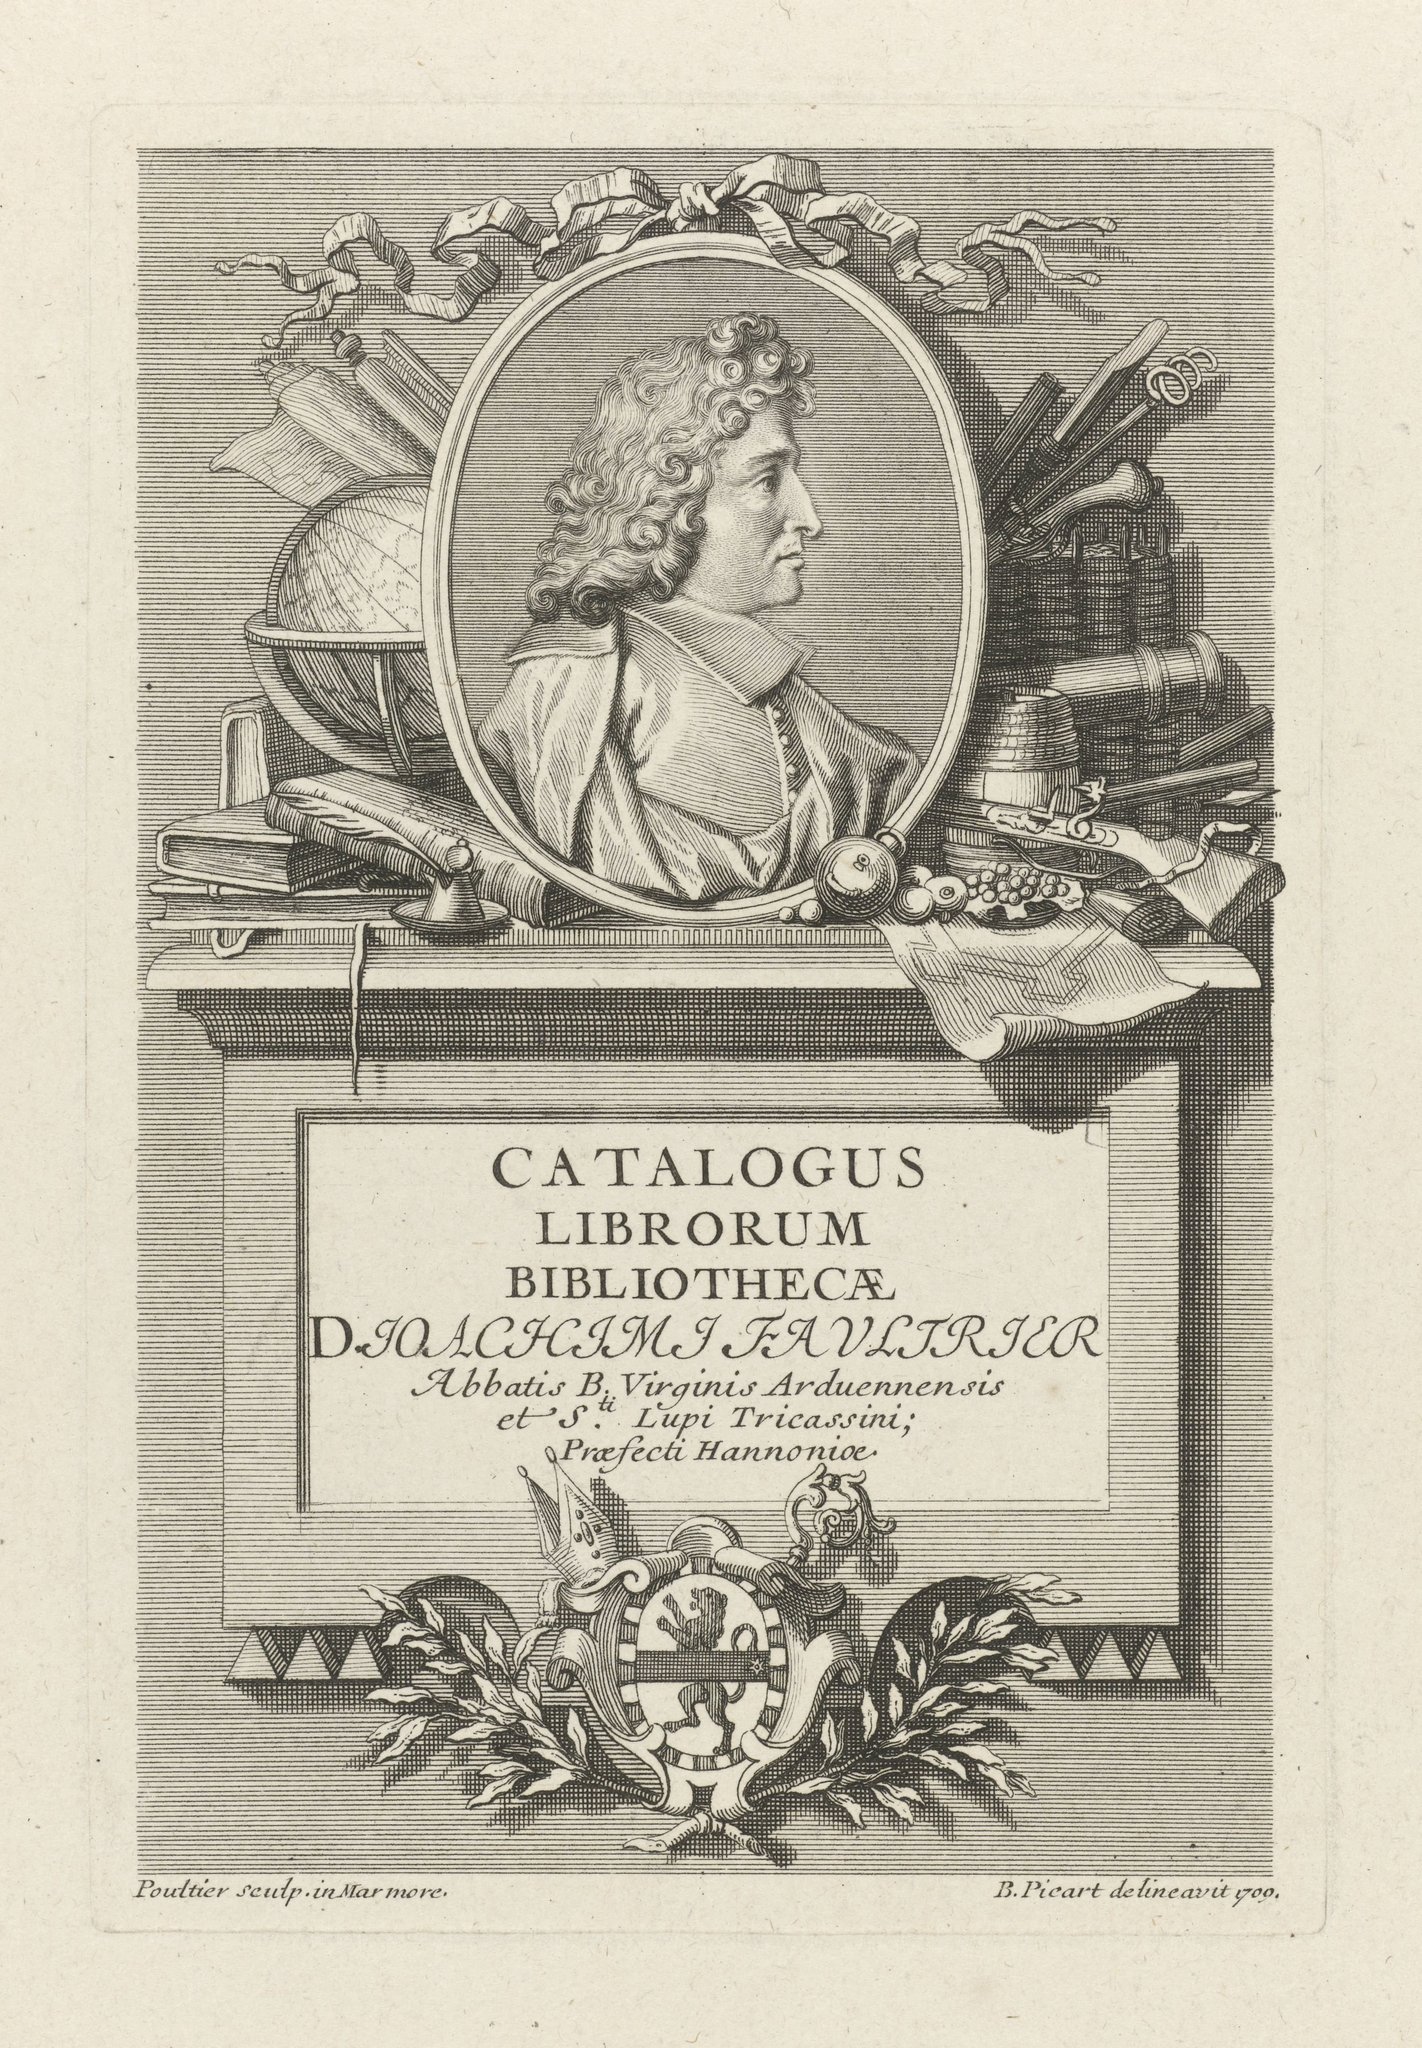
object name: titelblad, titelpagina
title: Portret van Joachim Faultrier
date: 1709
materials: paper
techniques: engraving, etching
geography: paris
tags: weapons, book, globe, armorial bearing, heraldry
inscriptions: collector's mark: Lugt 2228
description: Titelpagina met het portret van de schrijver Joachim Faultrier. De omlijsting van het portret wordt omringd door boeken, een globe, een schrijfveer en diverse wapens. In het kader de titel in het Latijn. Daaronder het wapenschild van de geportretteerde.